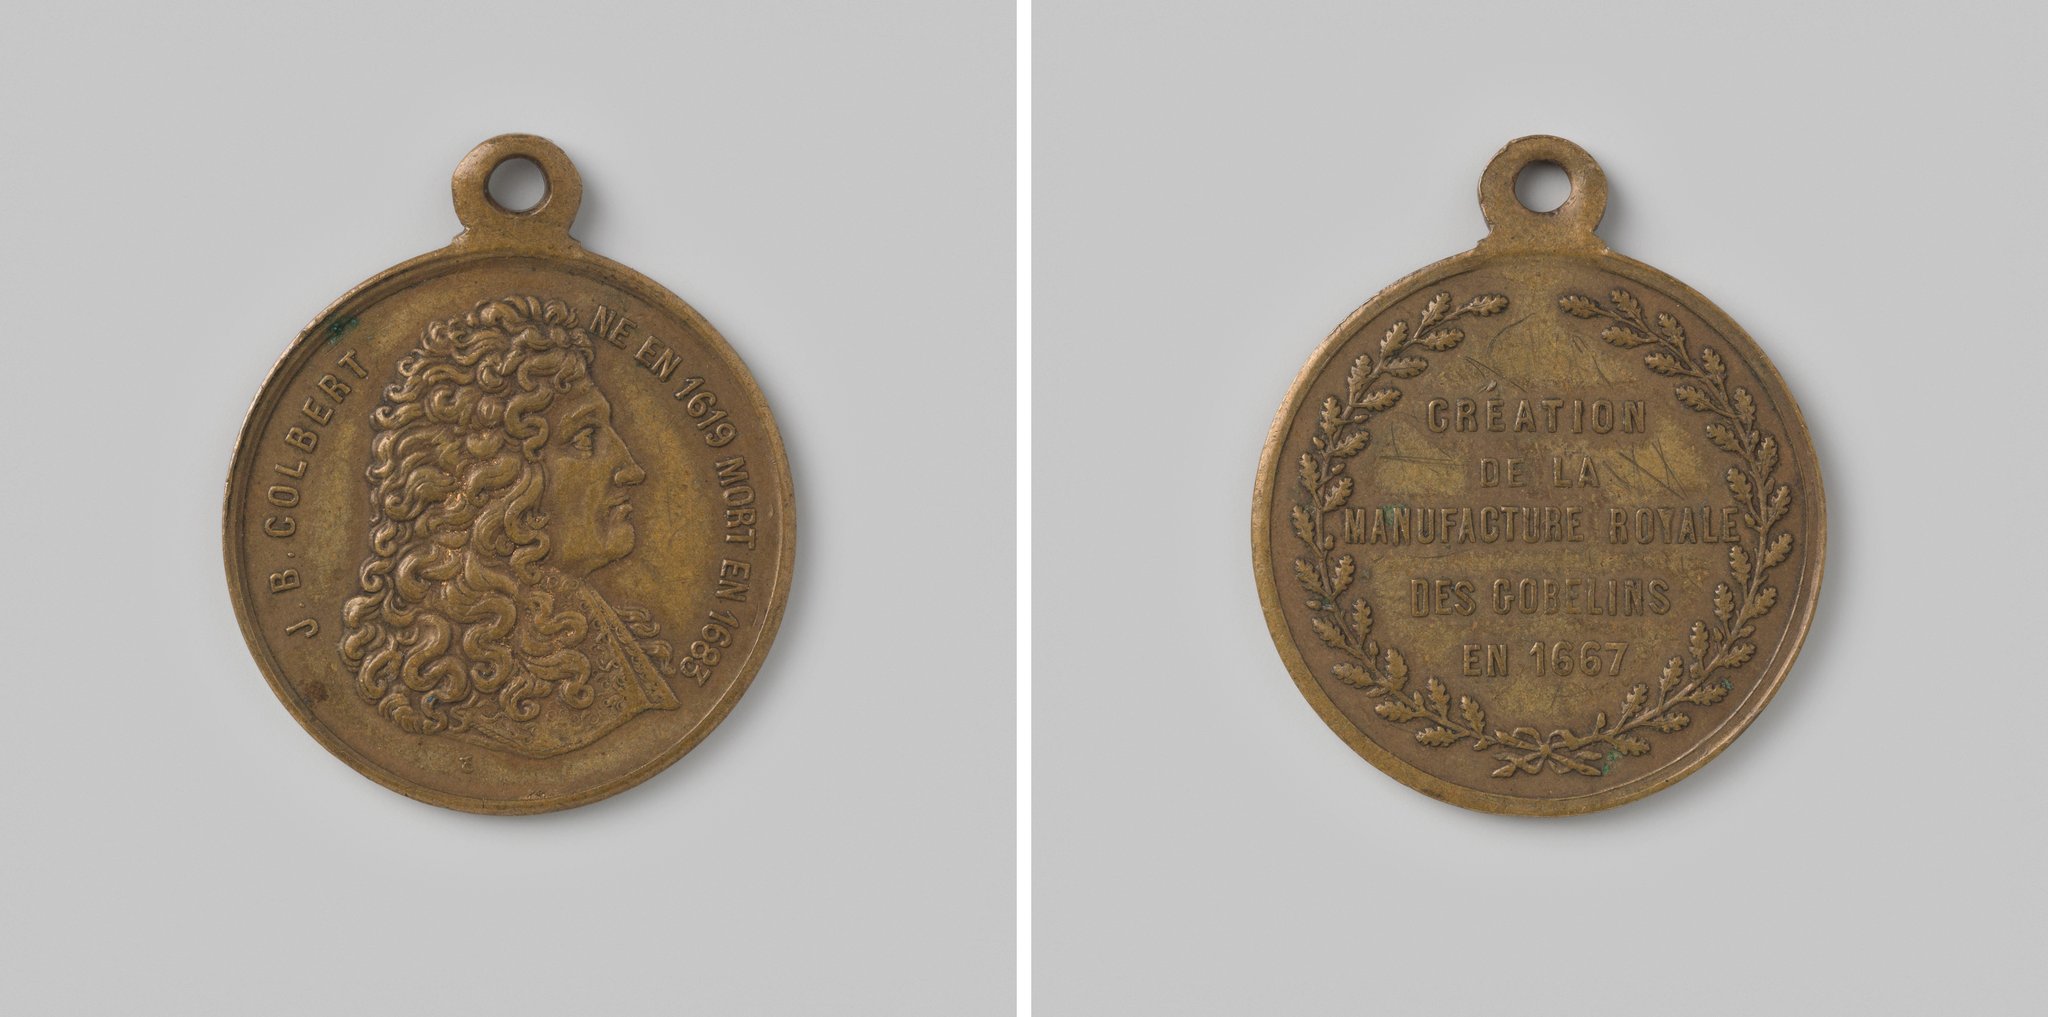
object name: history medal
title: Ter herdenking van de oprichting van de Manufacture Royale des Gobelins onder J.B. Colbert in 1667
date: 1867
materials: brass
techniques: striking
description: Messing penning met draagoog, op de voorzijde het borstbeeld van Colbert naar rechts met omschrift, op de keerzijde vijf regels tekst tussen samengestrikte eikentakken.